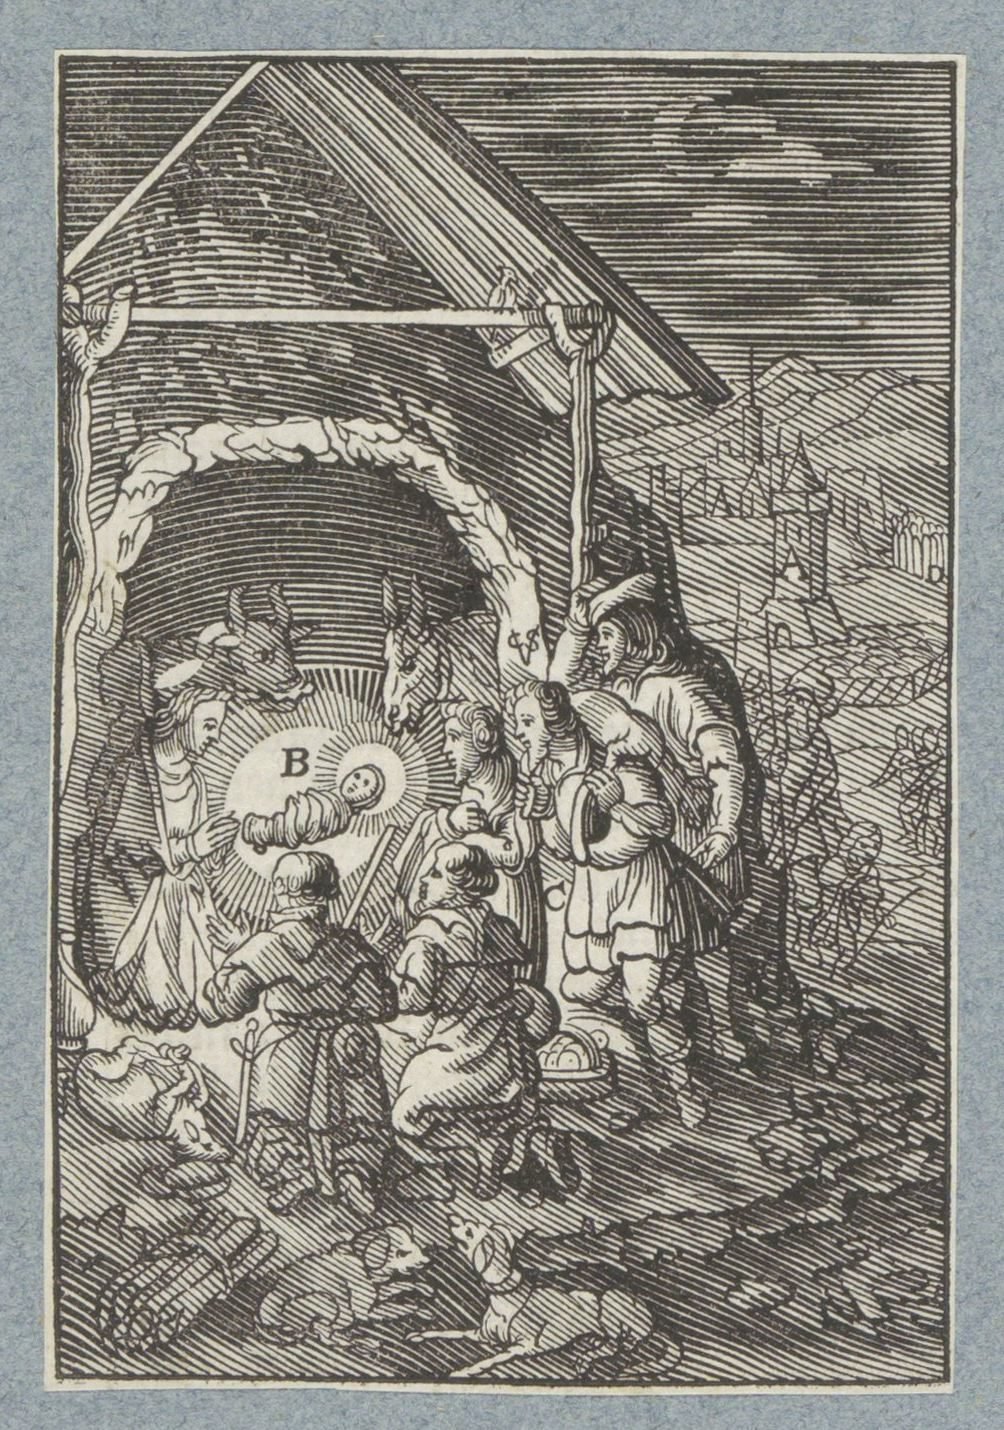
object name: print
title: Aanbidding door de herders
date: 1629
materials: paper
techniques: letterpress printing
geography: antwerp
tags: adoration of the christ-child by the shepherds; mary and joseph present, dog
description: De prent is afkomstig uit een van de uitgaven van P.J. Paets uit Amsterdam. De prent wordt voor het eerst gebruikt in: Der Zielen Lust-hof. Leuven, I.Jacbosz voor P.J. Paets [= Amsterdam, P.J. Paets], 1629. De voorstelling is gekopieerd naar een prent van Hieronymus Wierix voor: Nadal, Jerónimo. Evangelicae Historiae Imagines. Antwerpen, M. Nutius, 1593.